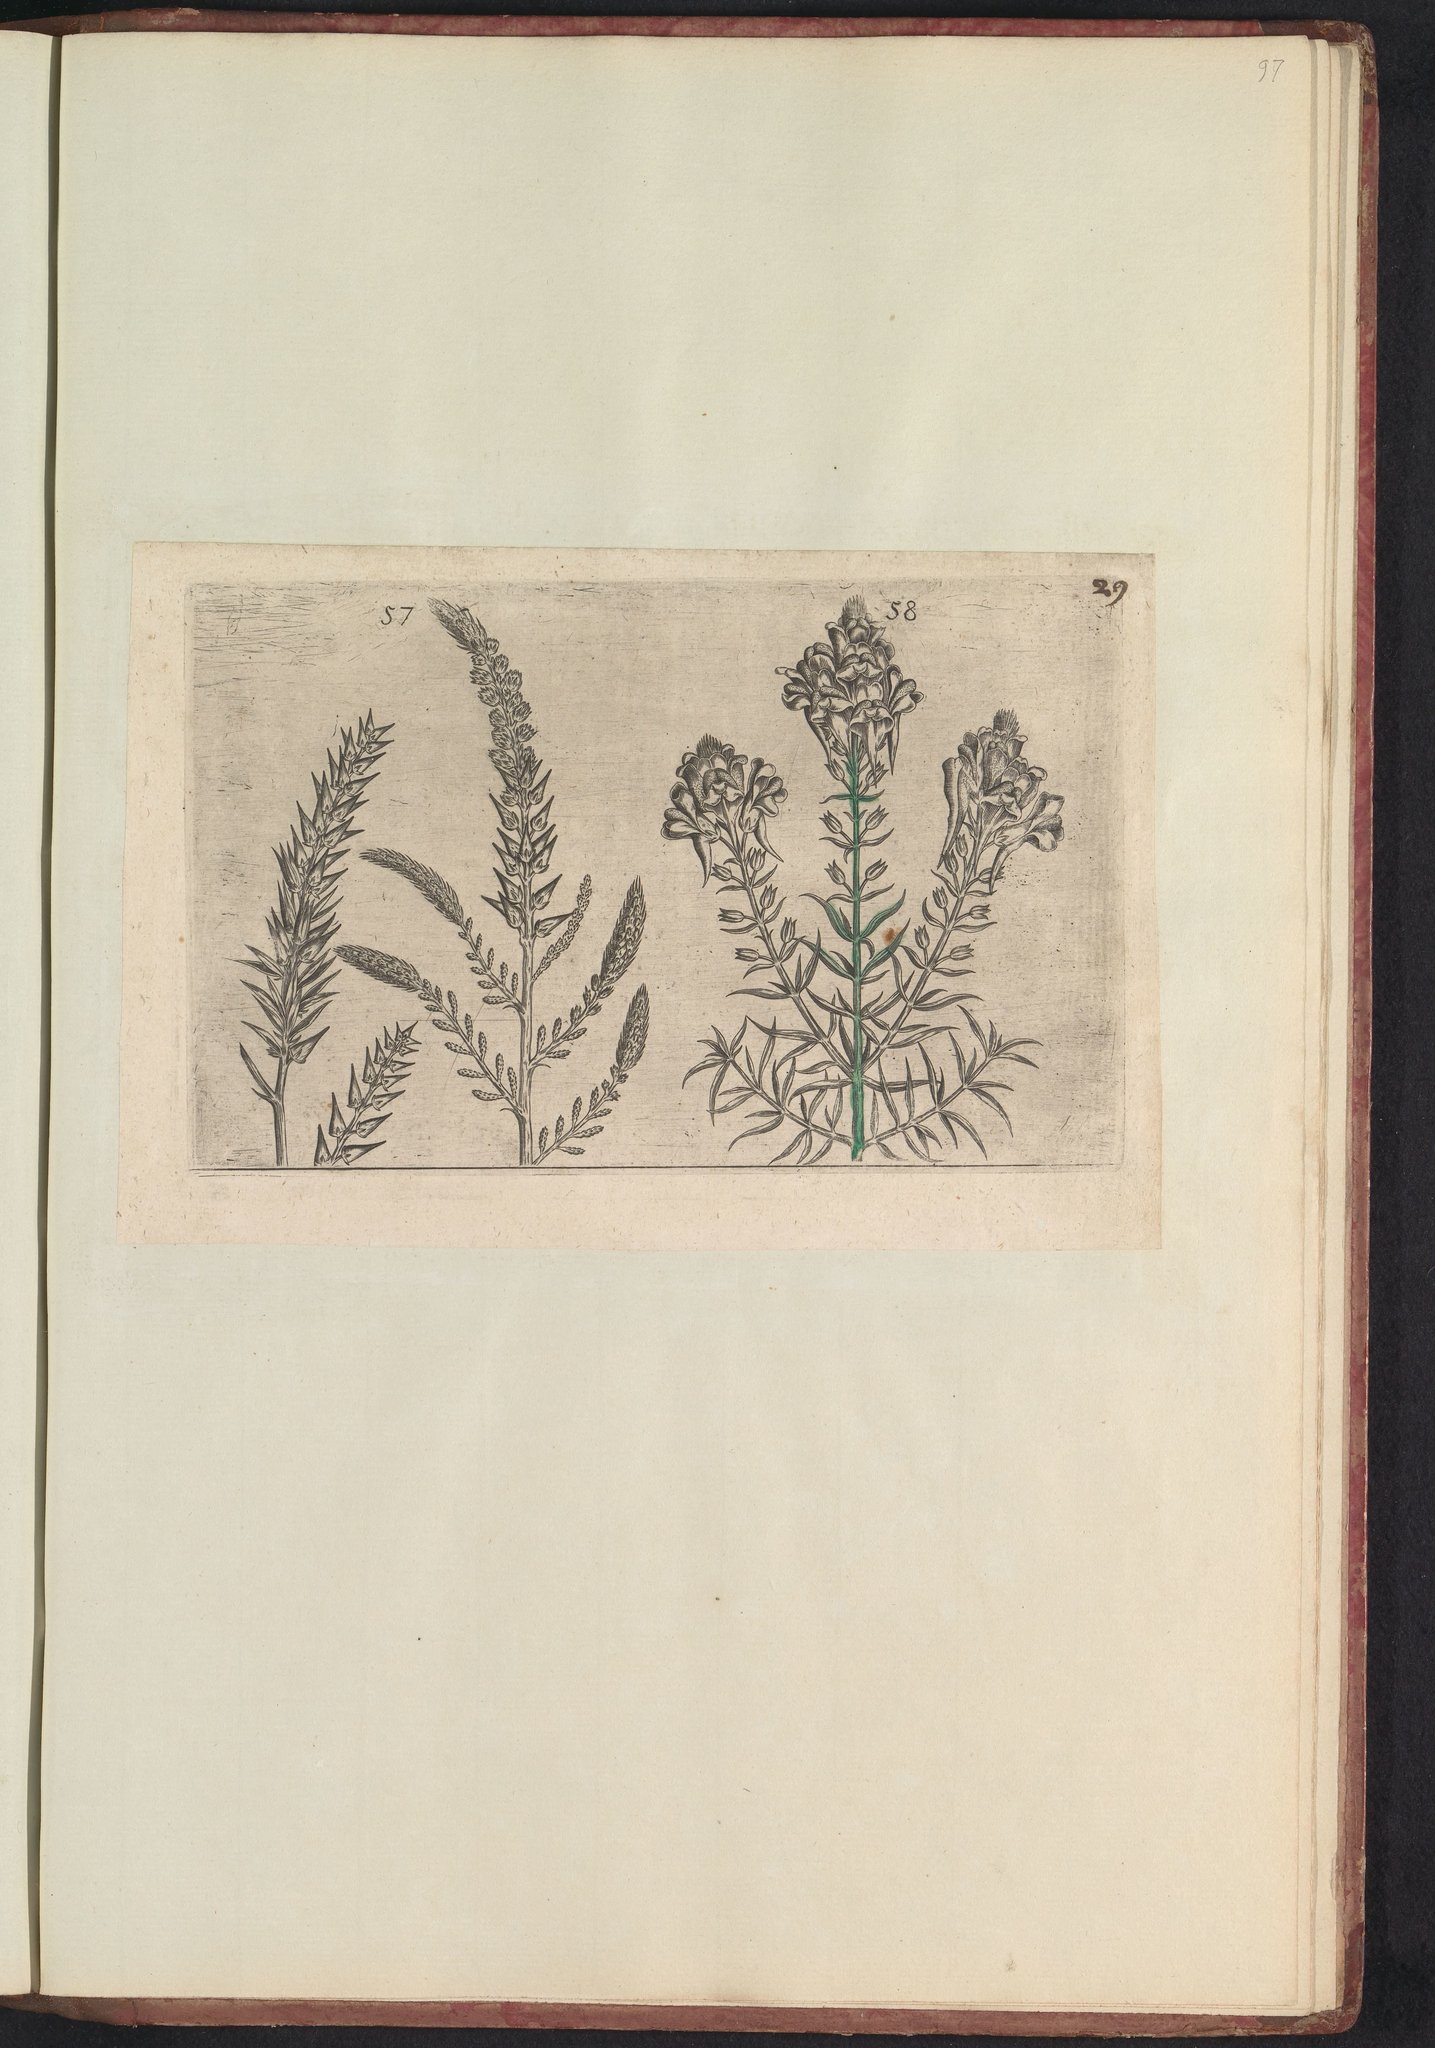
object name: print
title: Tamarisk (Tamarix gallica) en vlasbekje (Linaria vulgaris)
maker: Anonymous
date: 1604-1632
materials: ink, paper, watercolor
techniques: engraving, hand coloring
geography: southern netherlands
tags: flowers: tamarisk, flowers: toadflax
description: Tamarisk en vlasbekje. Figs. 57 en 58 op een blad met de hand genummerd 29. In: Anselmi Boëtii de Boot I.C. Brugensis & Rodolphi II. Imp. Roman. medici a cubiculis Florum, Herbarum, ac fructuum selectiorum icones, & vires pleraeque hactenus ignotæ. Onderdeel van het album met bladen en platen uit De Boodts herbarium van 1640. Het twaalfde van twaalf albums met aquarellen van dieren, vogels en planten bekend rond 1600, gemaakt in opdracht van keizer Rudolf II.